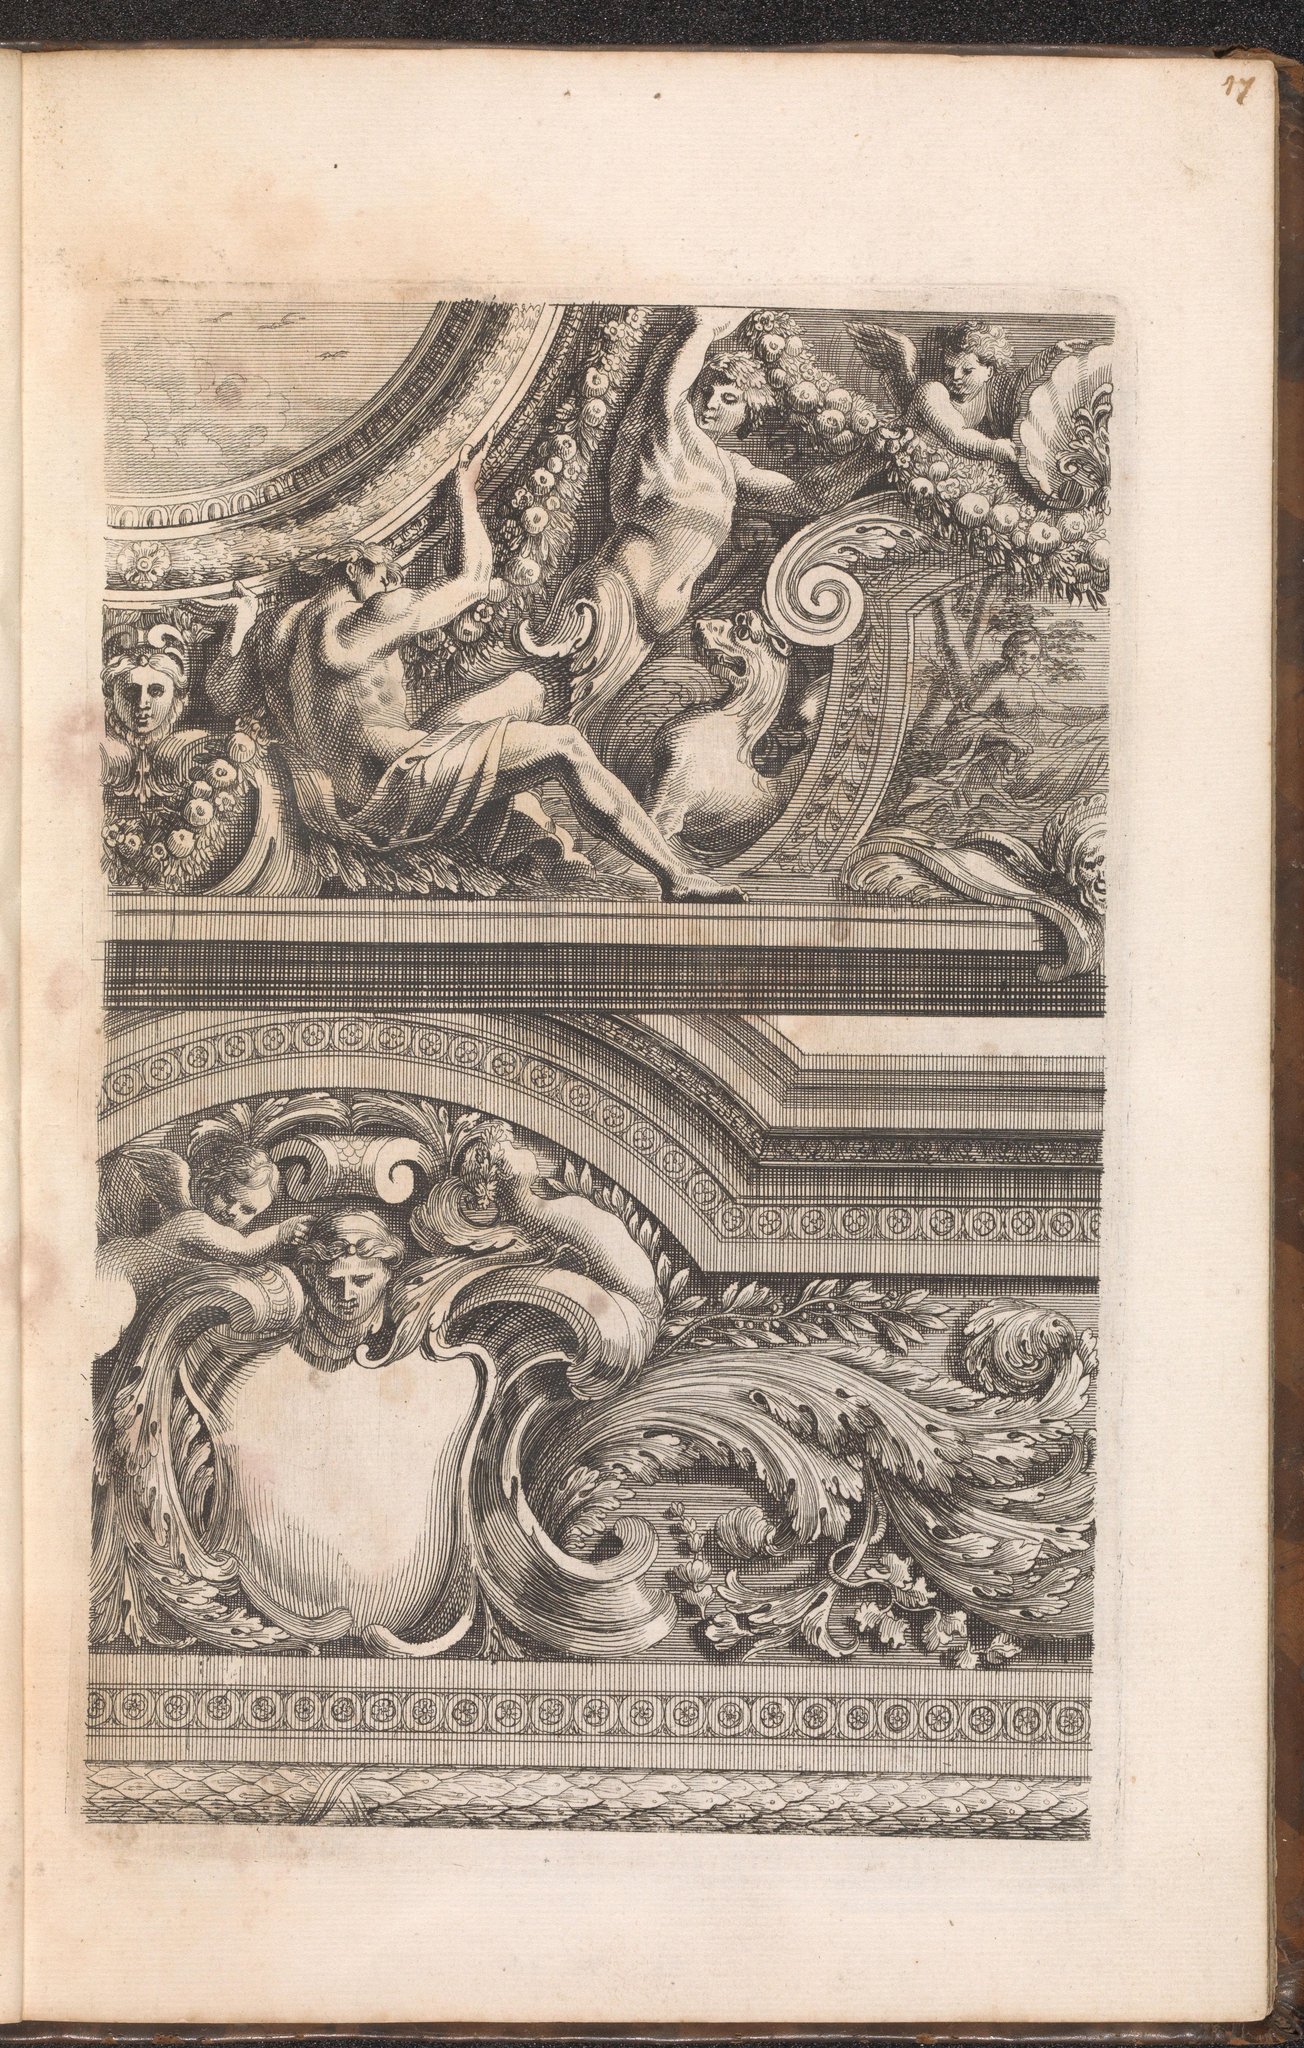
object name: album leaf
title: Varie soffiti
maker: cornelis galle (ii)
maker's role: print maker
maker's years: 1615-1678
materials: paper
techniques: etching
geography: antwerp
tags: ornaments ~ art, ornament ~ cartouche, (decorated) ceiling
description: De cartouche is bekroond met een masker. Uit serie van 6 bladen met tegenzijdige kopieën naar een serie zonder titel van Jean Lepautre, voor het eerst uitgegeven rond 1650. Prent maakt deel uit van een album.